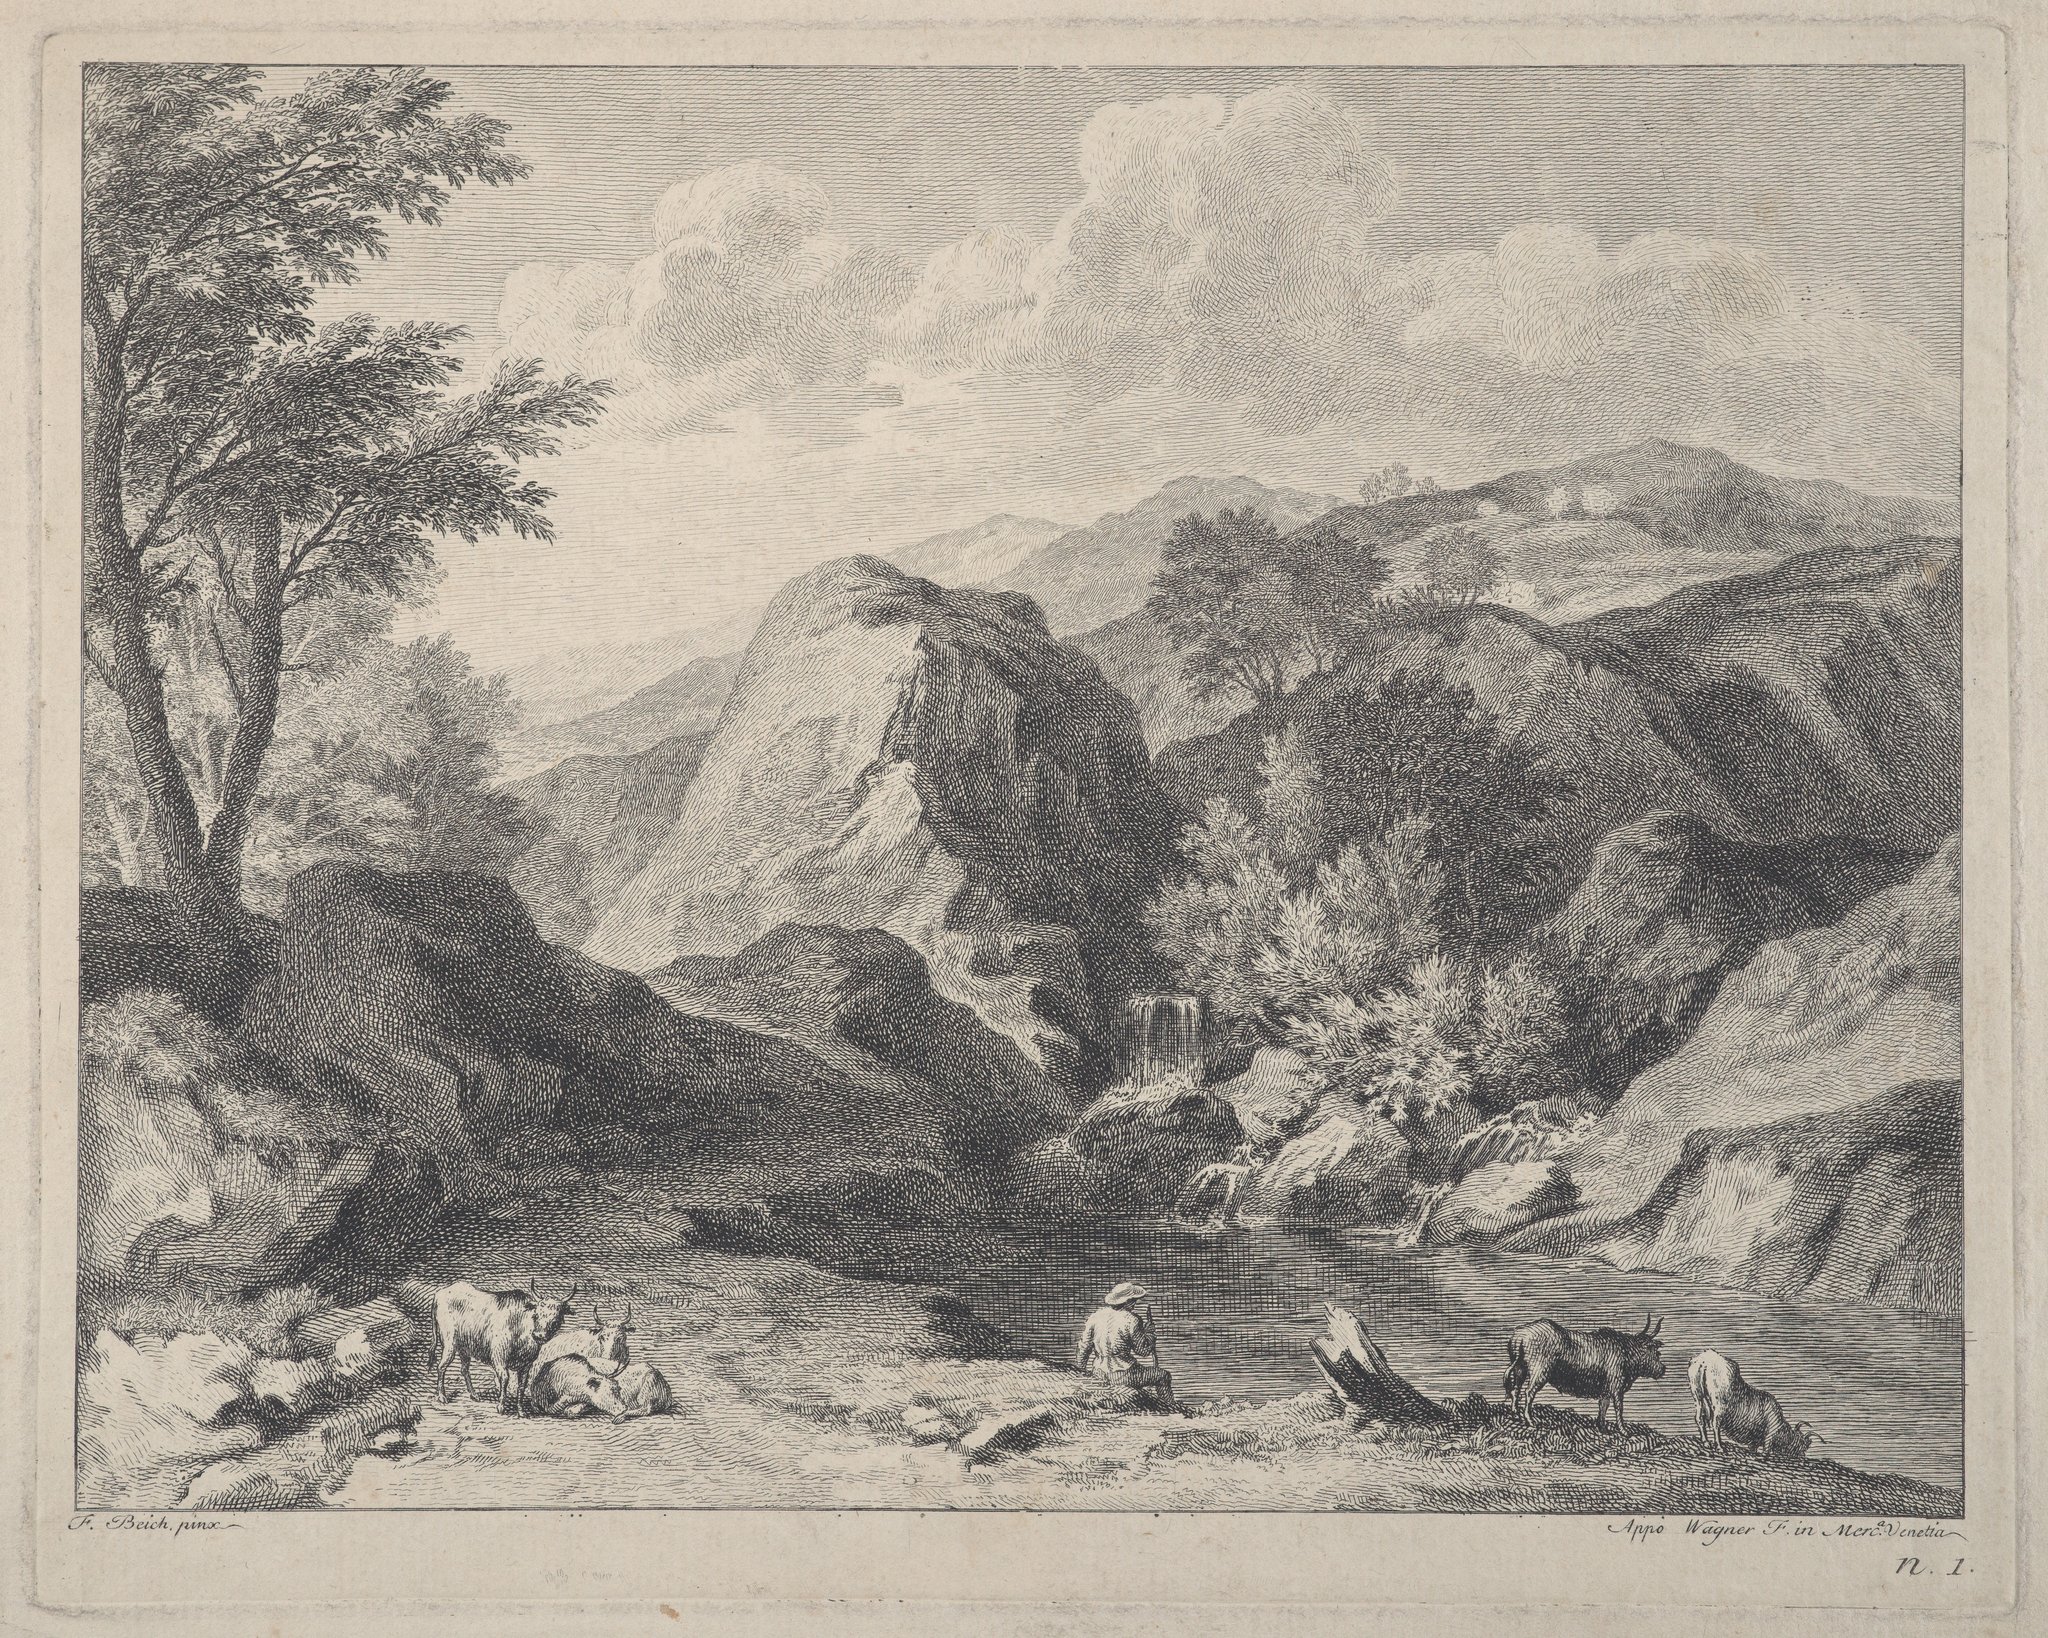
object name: print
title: Mountainous landscape with herdsmen and cows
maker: joseph wagner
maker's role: artist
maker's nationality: italian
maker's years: 1706-1780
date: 1725-1780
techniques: etching